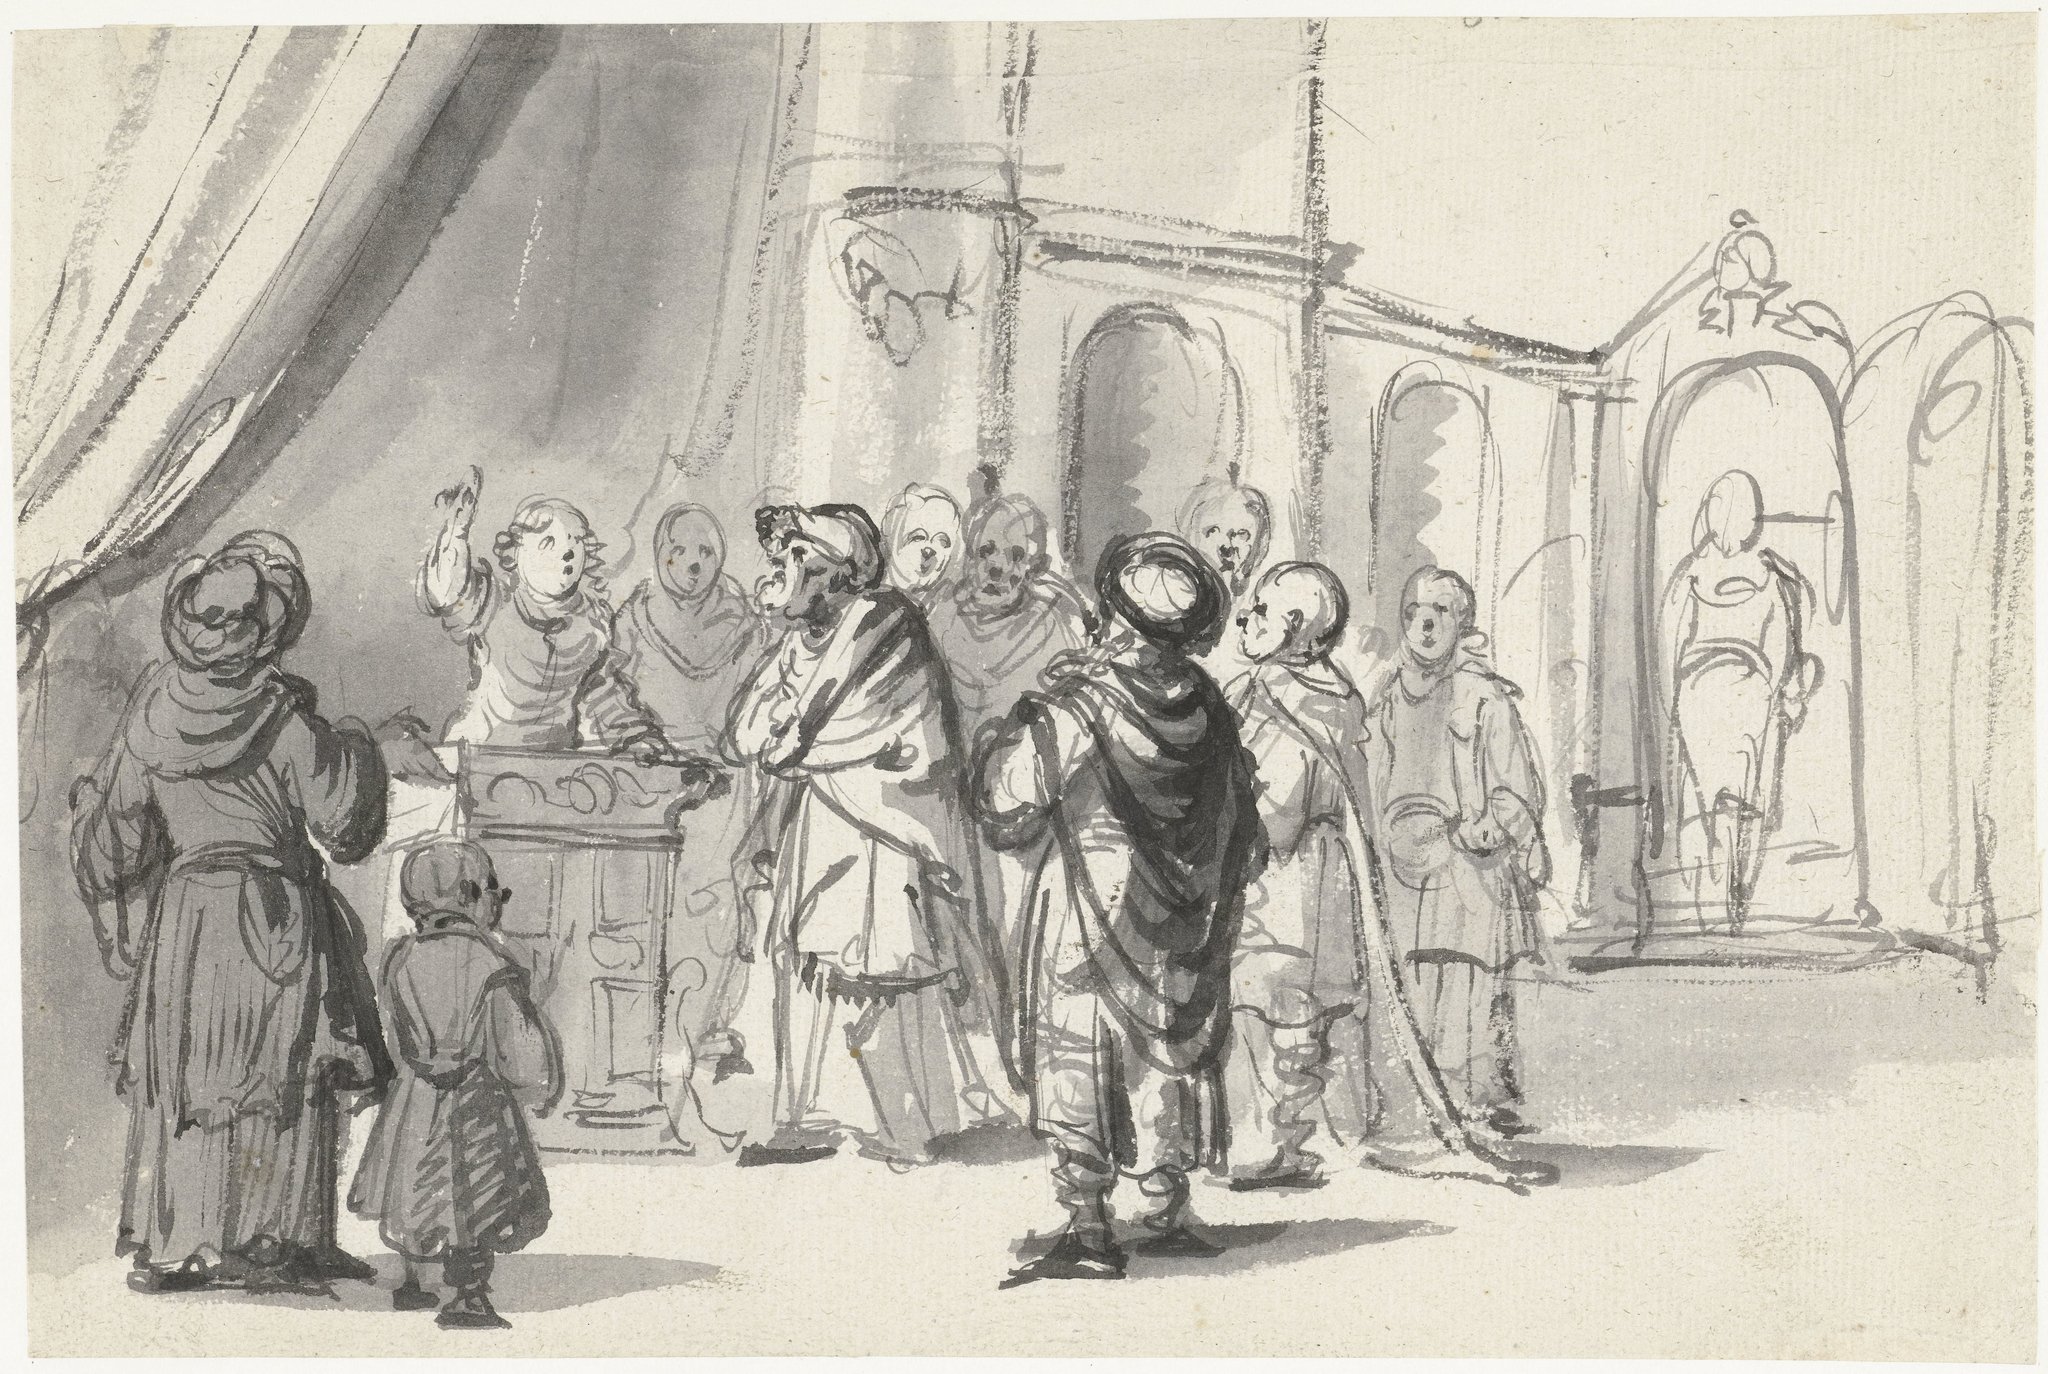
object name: drawing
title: Christus en de schriftgeleerden (?)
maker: moses ter borch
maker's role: draughtsman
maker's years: 1645-1667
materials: ink, paper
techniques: brush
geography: zwolle